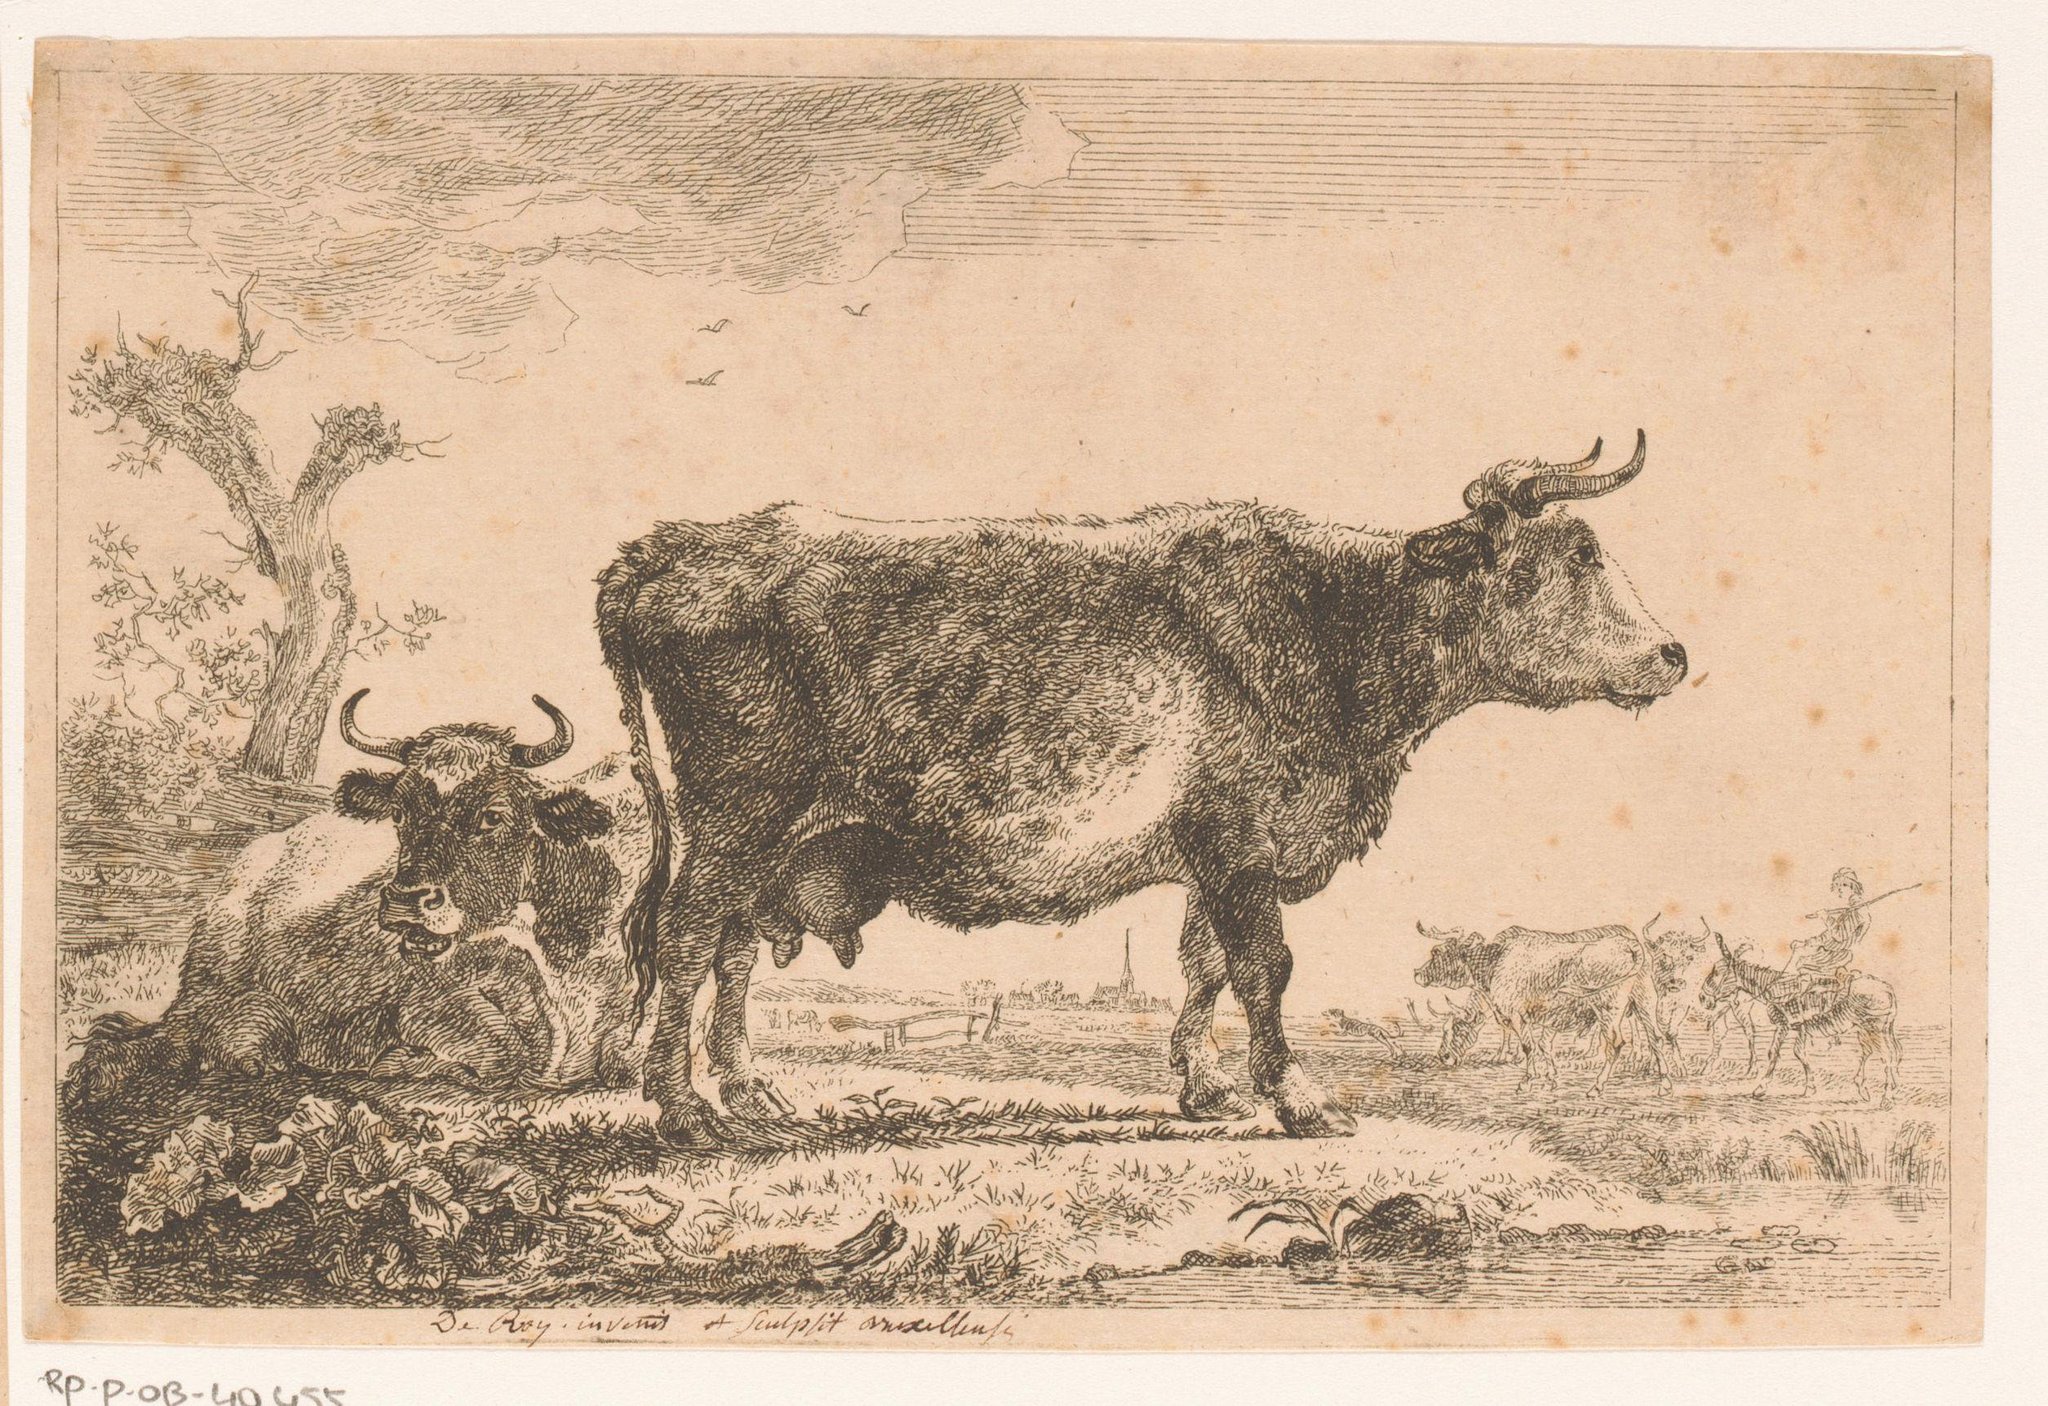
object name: print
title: Runderen in een landschap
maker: jean baptiste de roy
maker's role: print maker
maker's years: 1759-1839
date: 1769-1839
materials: paper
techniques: etching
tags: cow, ass, donkey